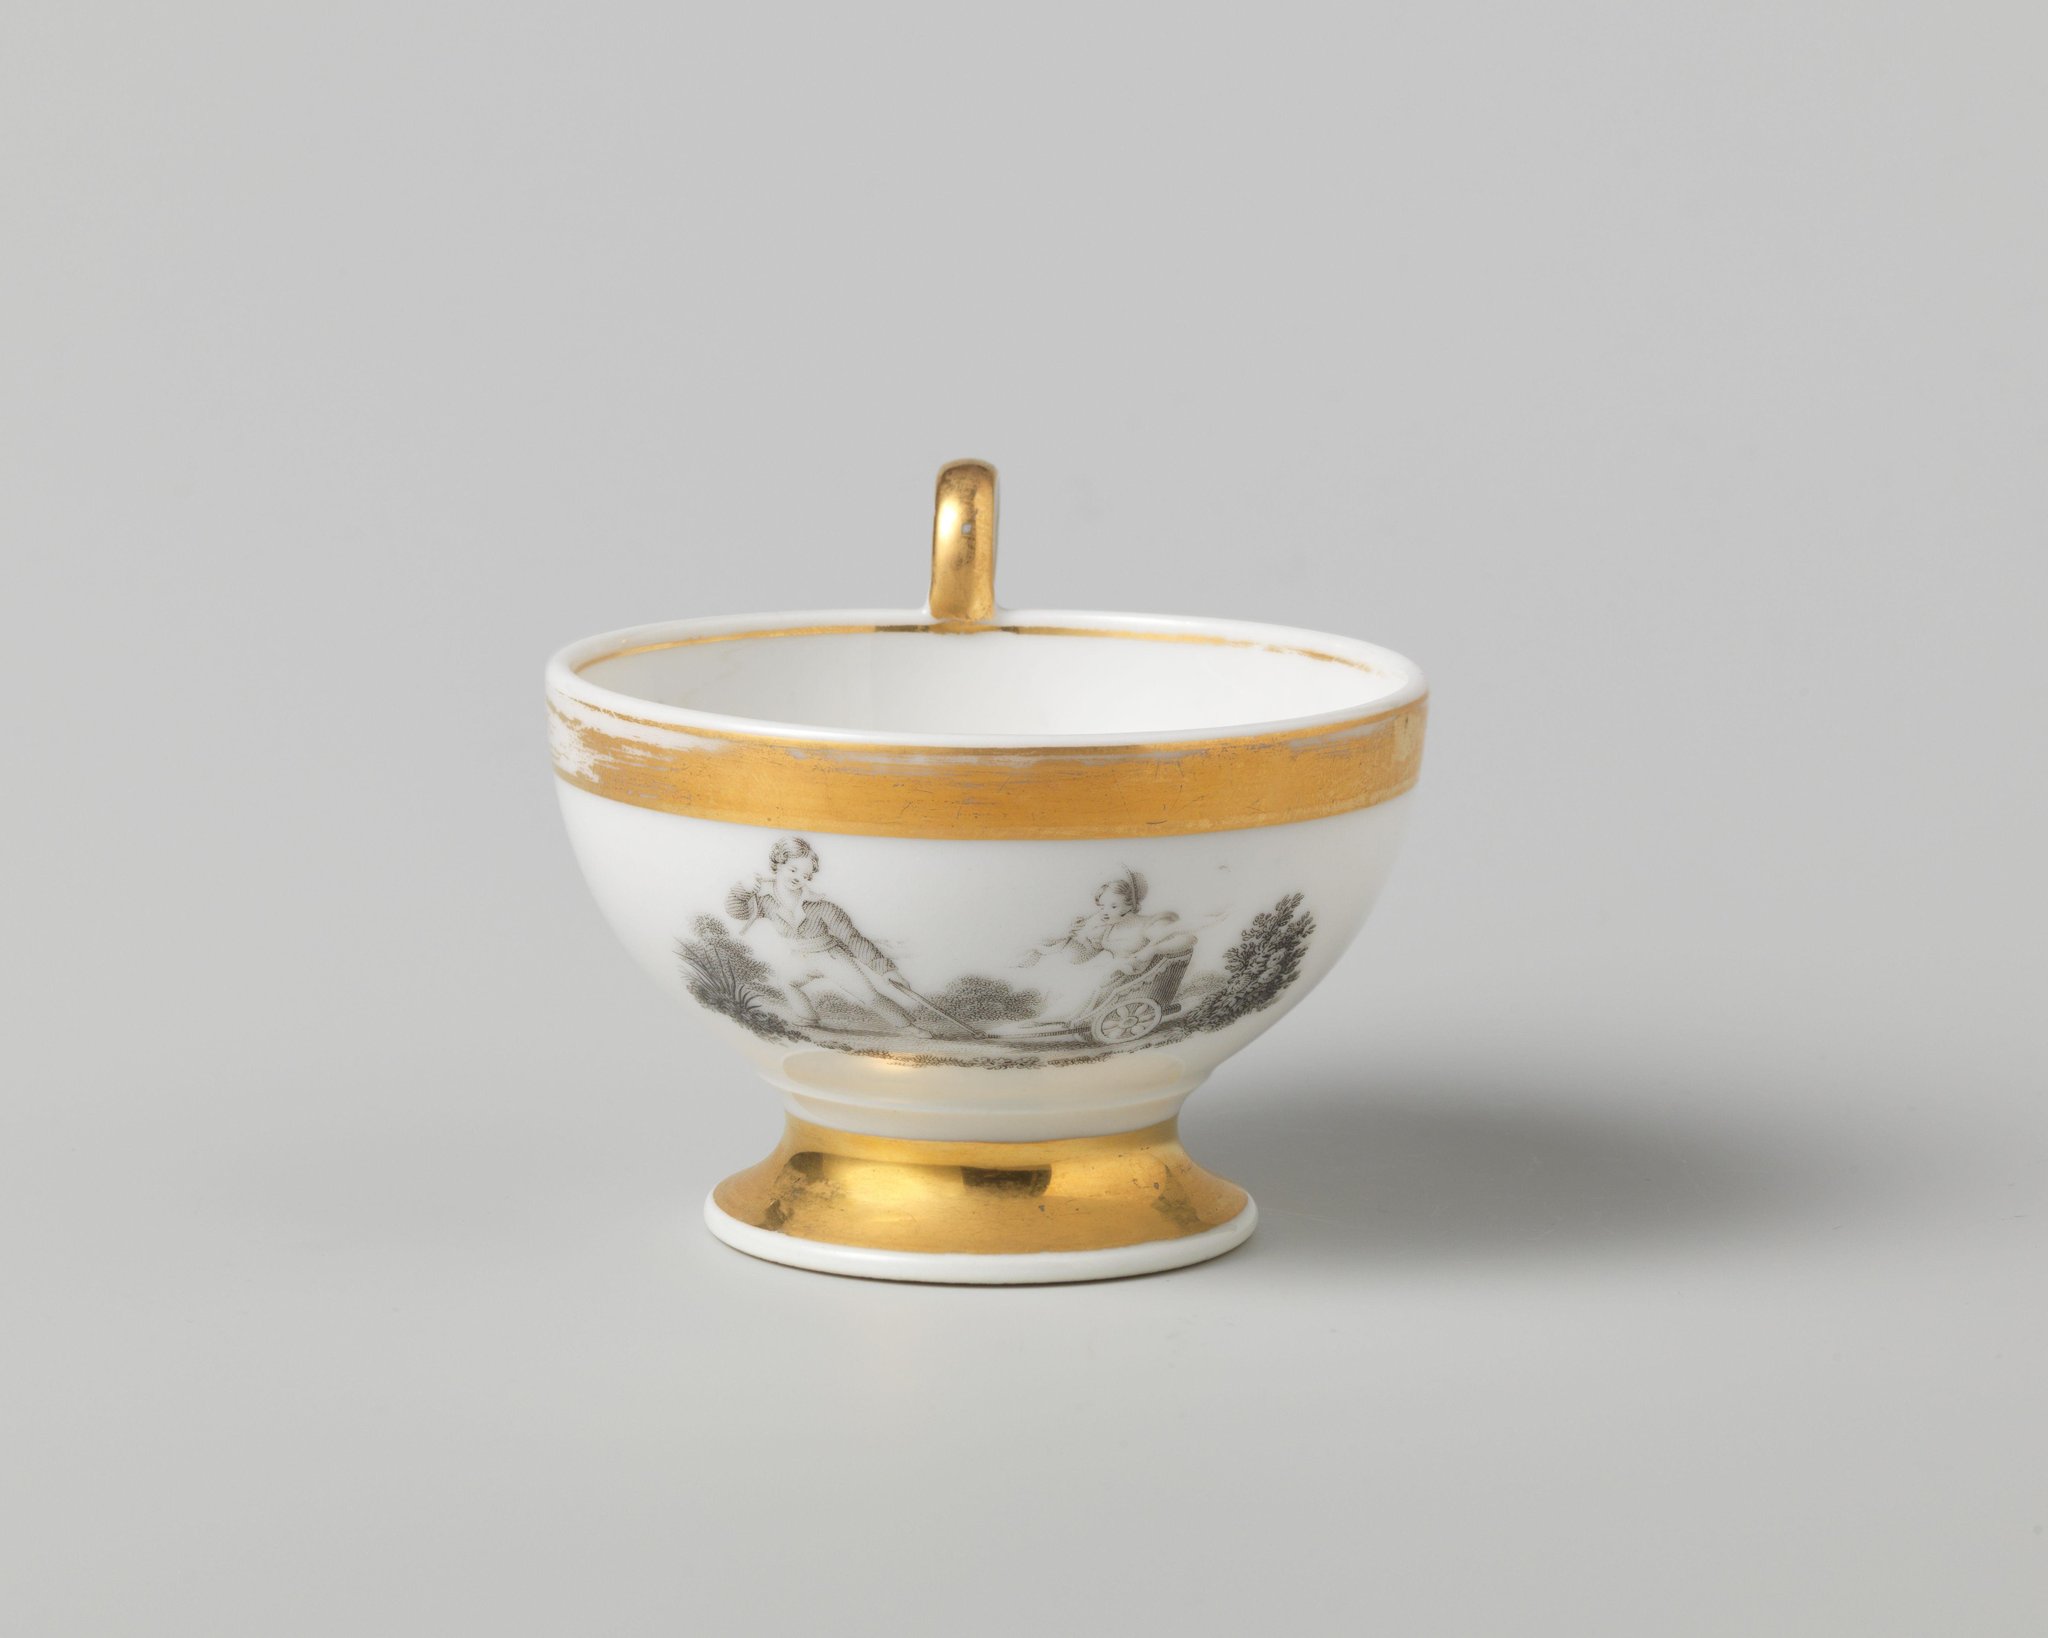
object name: cup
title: Cup with different figures in a landscape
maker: Anonymous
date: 1850-1899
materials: glaze, gold, paint, porcelain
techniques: firing, forming, gilding, turning, vitrification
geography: europe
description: Kop van porselein, op hoge voet en met vraagtekenvormig oor. Behoort tot een serie van twaalf kop en schotels. Langs de mondrand een brede gouden bies, het oor is verguld. De kop is versierd met een drukdecor in zwart, voorstellende spelende kinderen of volwassenen in een landschap.